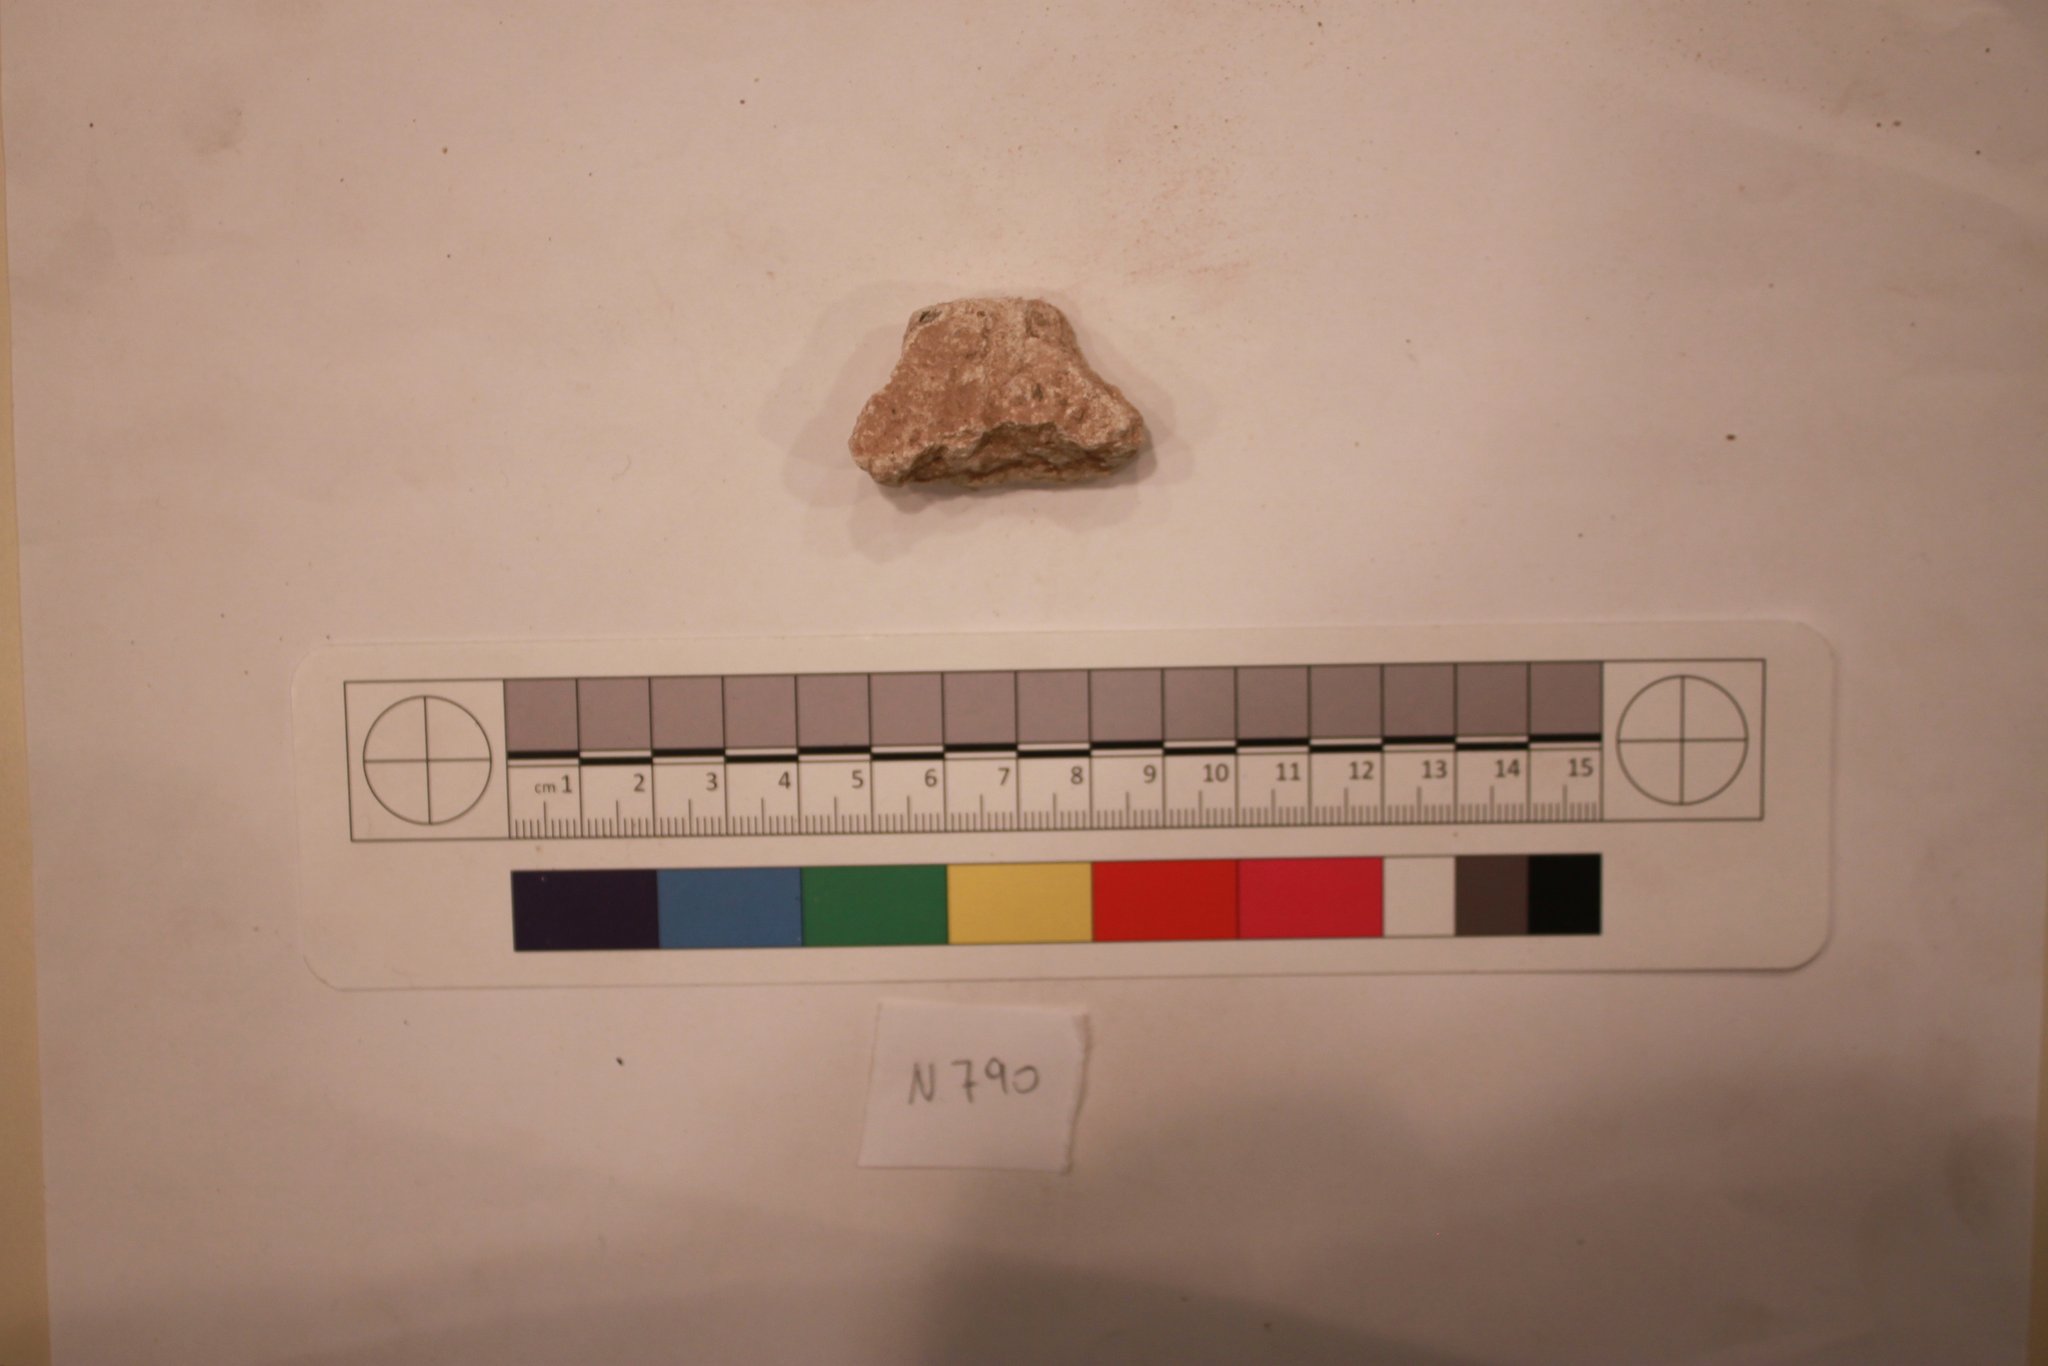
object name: fragment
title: Stucco Fragment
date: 701-1200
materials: plaster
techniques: carving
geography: iran